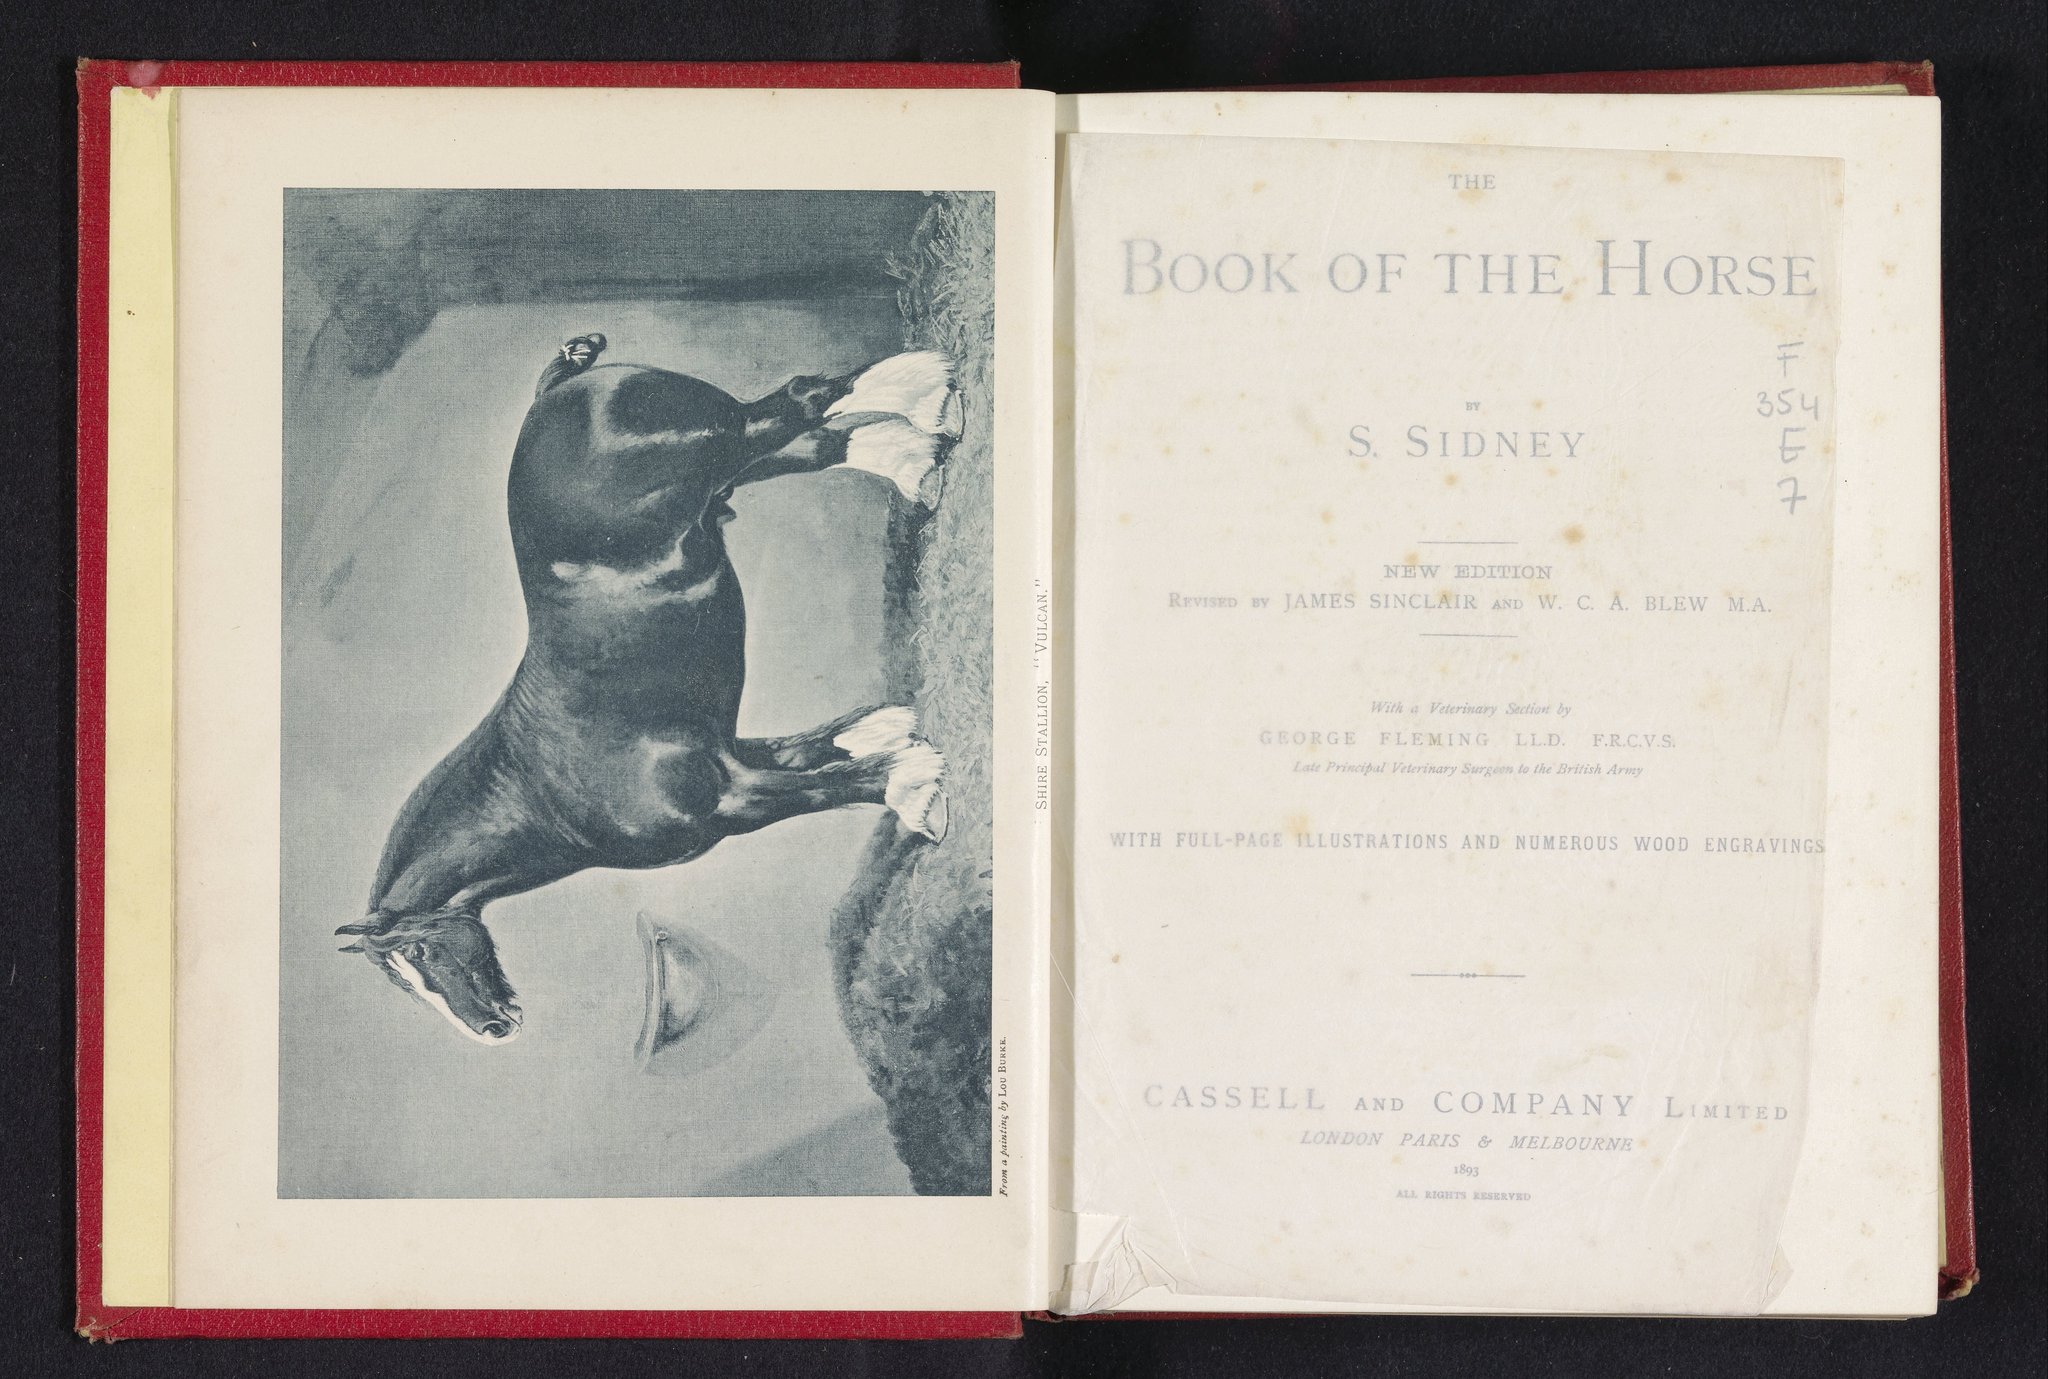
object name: page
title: Fotoreproductie van een schilderij van een Shire paard door Lou Burke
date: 1883-1893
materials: paper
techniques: photograph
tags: horse